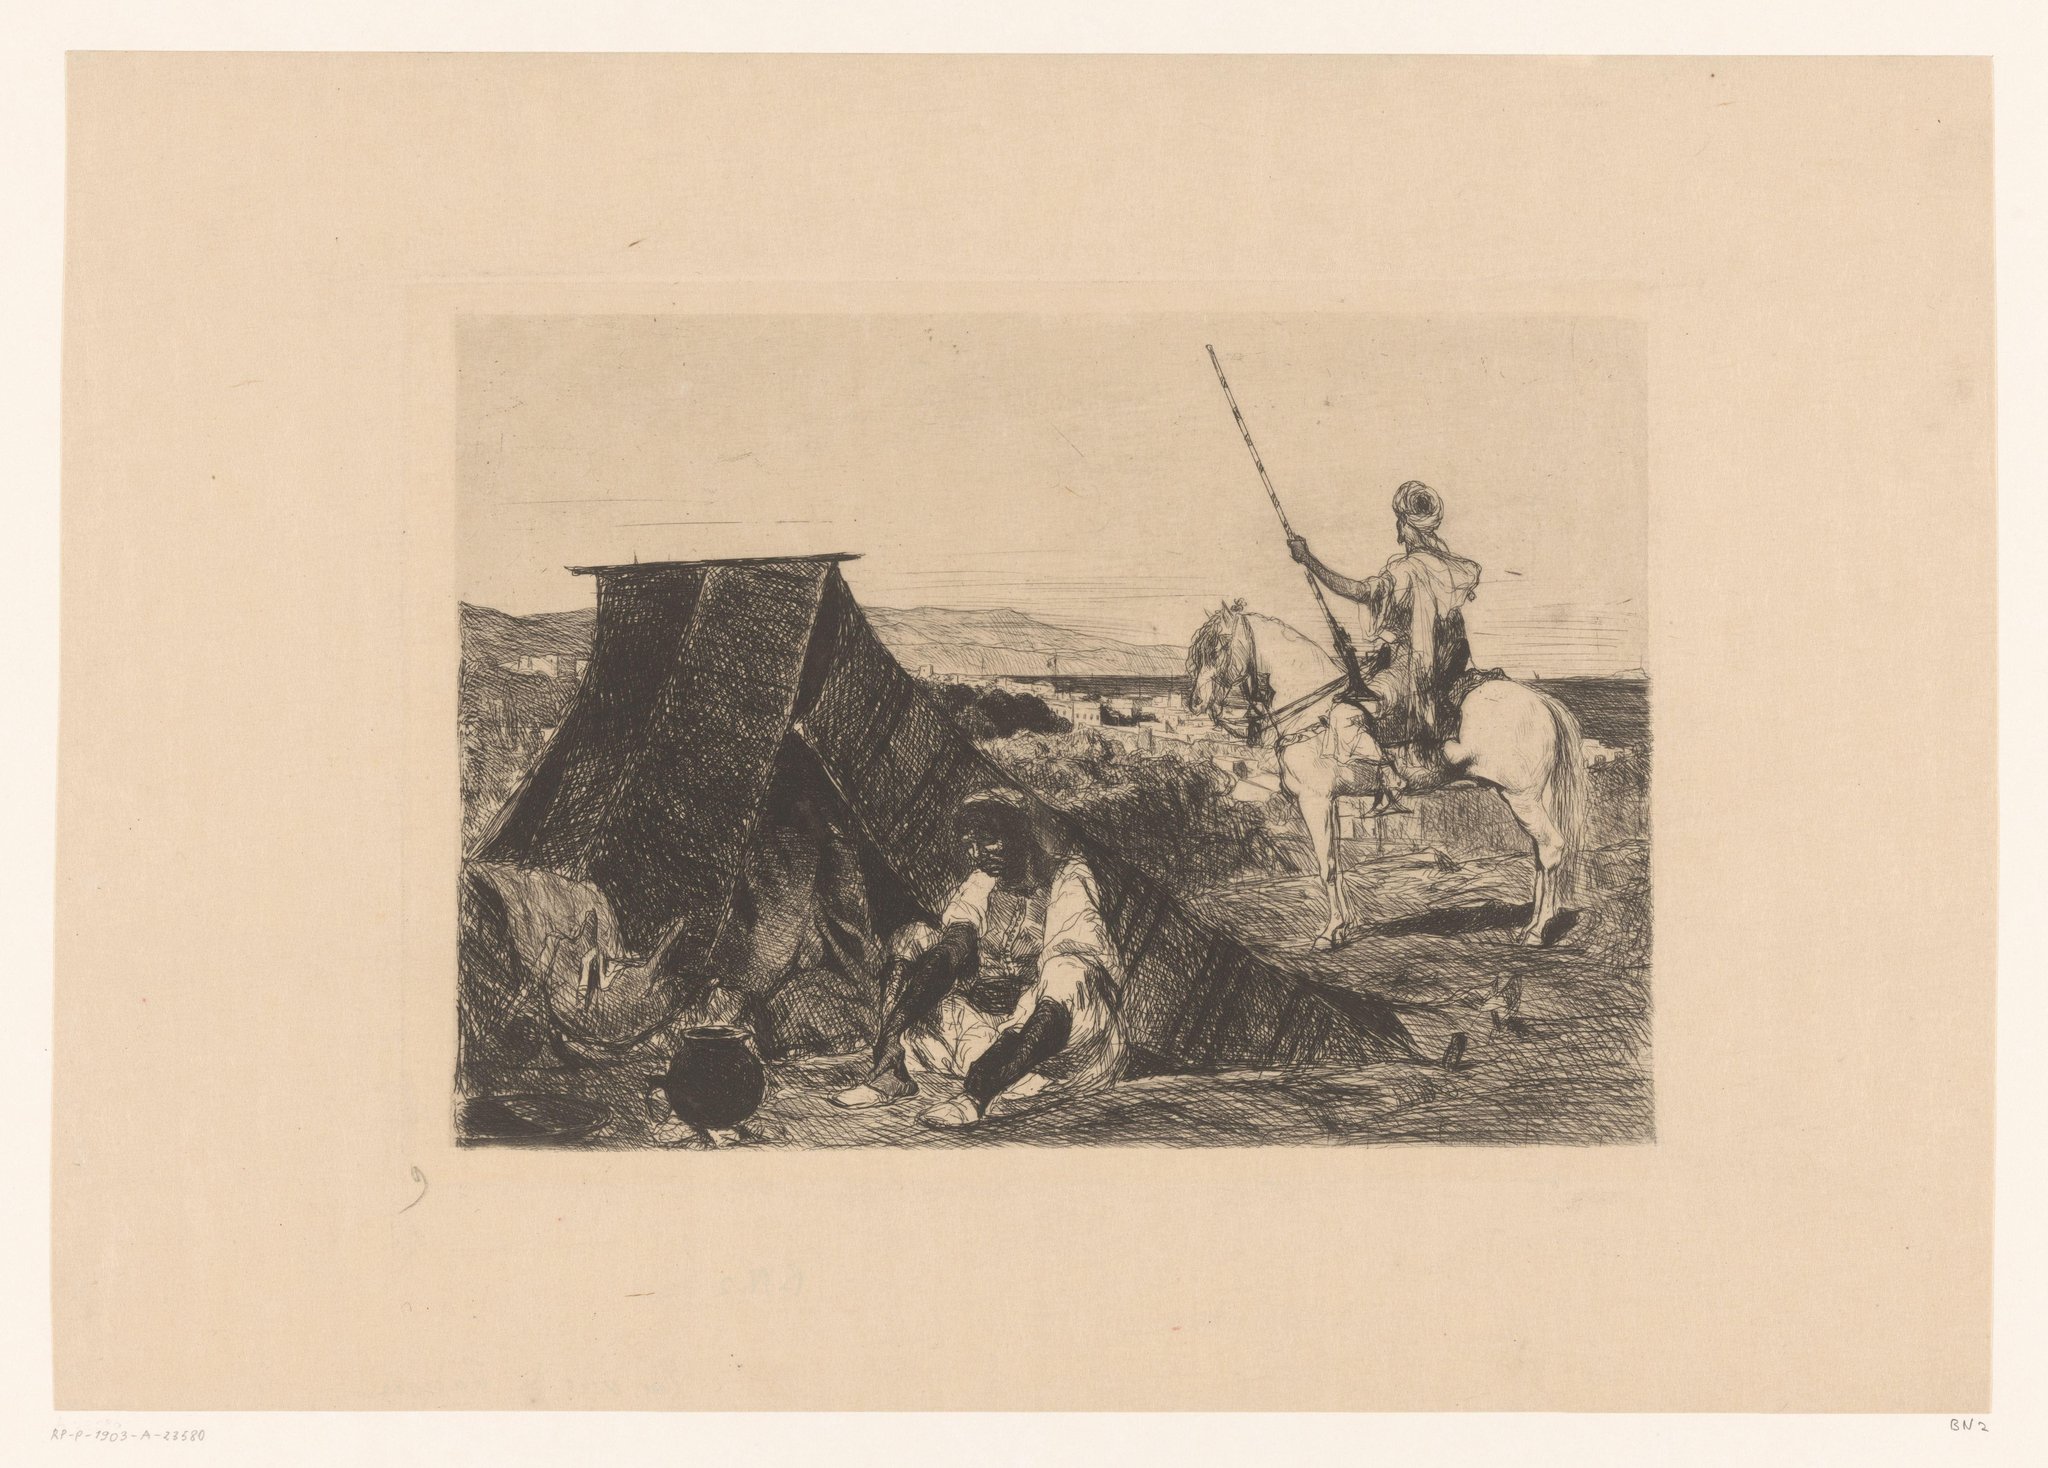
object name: print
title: Landschap met tent en ruiter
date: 1877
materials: paper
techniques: drypoint, etching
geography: paris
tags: riding a horse, ass, or mule; rider, horseman, landscapes, tent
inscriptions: collector's mark: Lugt 2228